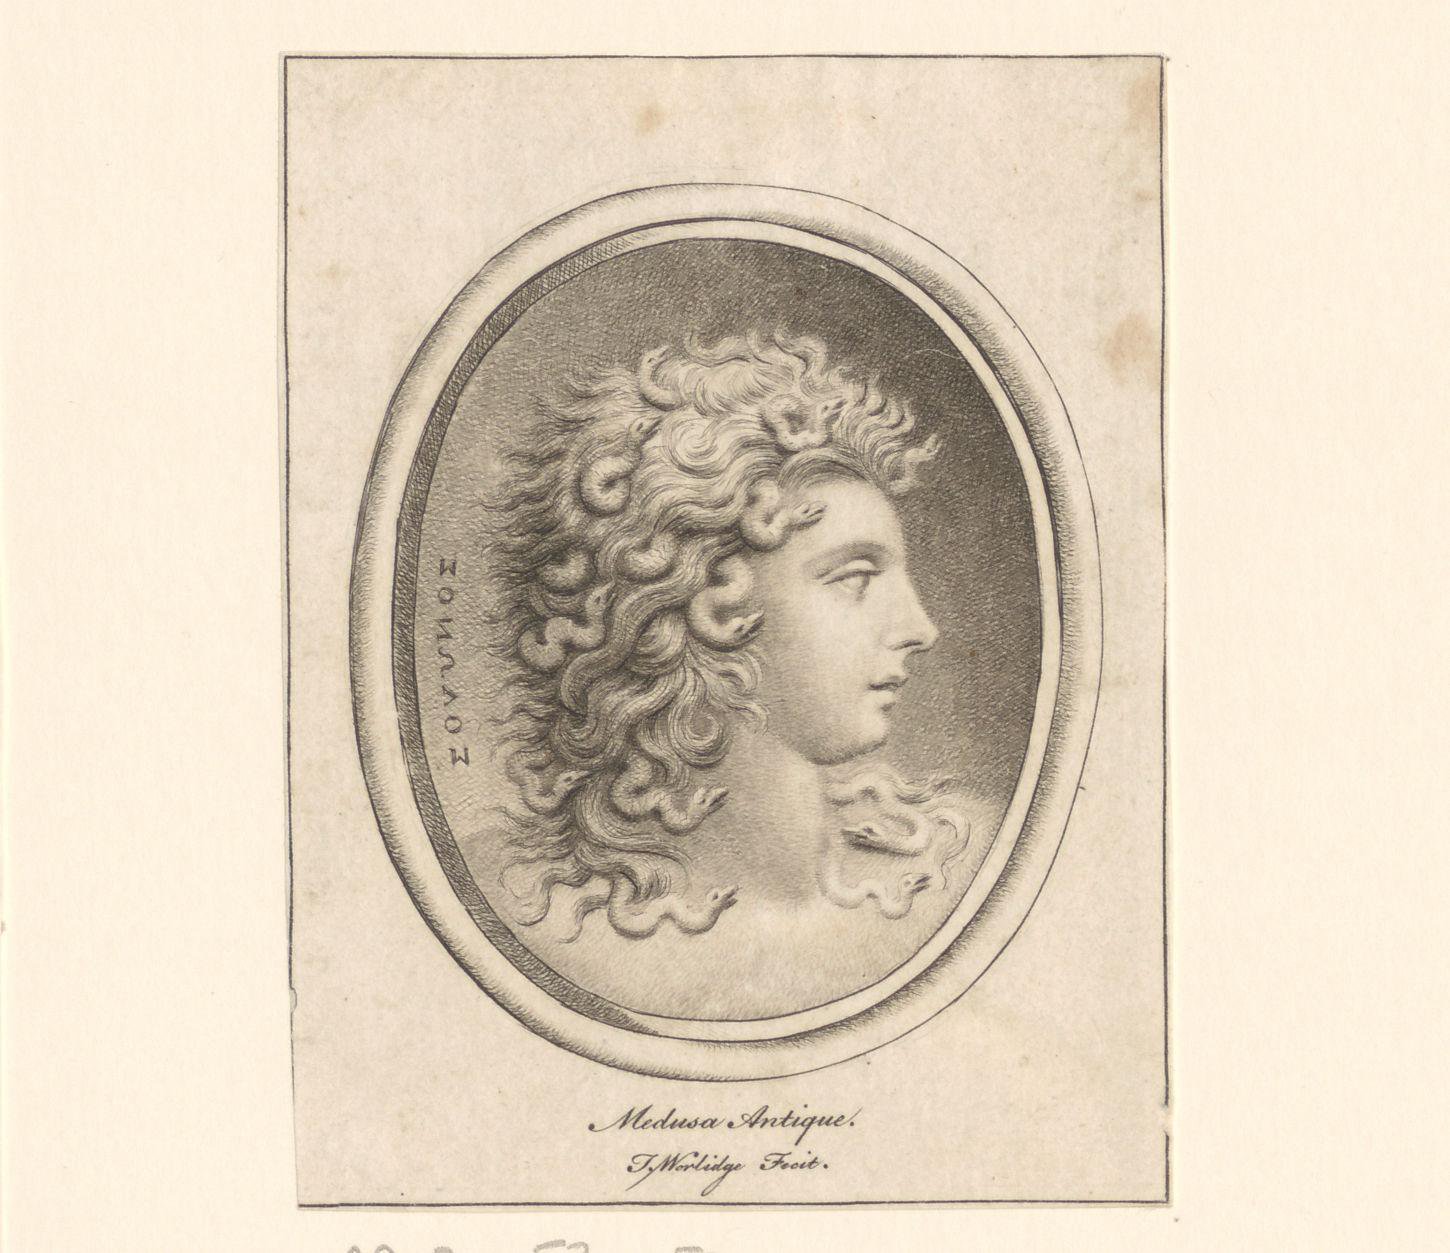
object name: print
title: A Select Collection of Drawings from Curious Antique Gems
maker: thomas worlidge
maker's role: print maker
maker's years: 1700-1766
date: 1768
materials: paper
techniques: etching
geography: london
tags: medusa (one of the gorgons), gem, gemstone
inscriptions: collector's mark: Lugt 2228, collector's mark: Lugt 2760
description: Worlidge maakte prenten voor de serie vanaf ca. 1754. Na zijn dood werden de prenten gebundeld in: Worlidge, Thomas. A Select Collection of Drawings from Curious Antique Gems (...). Londen: M. Worlidge, 1768.